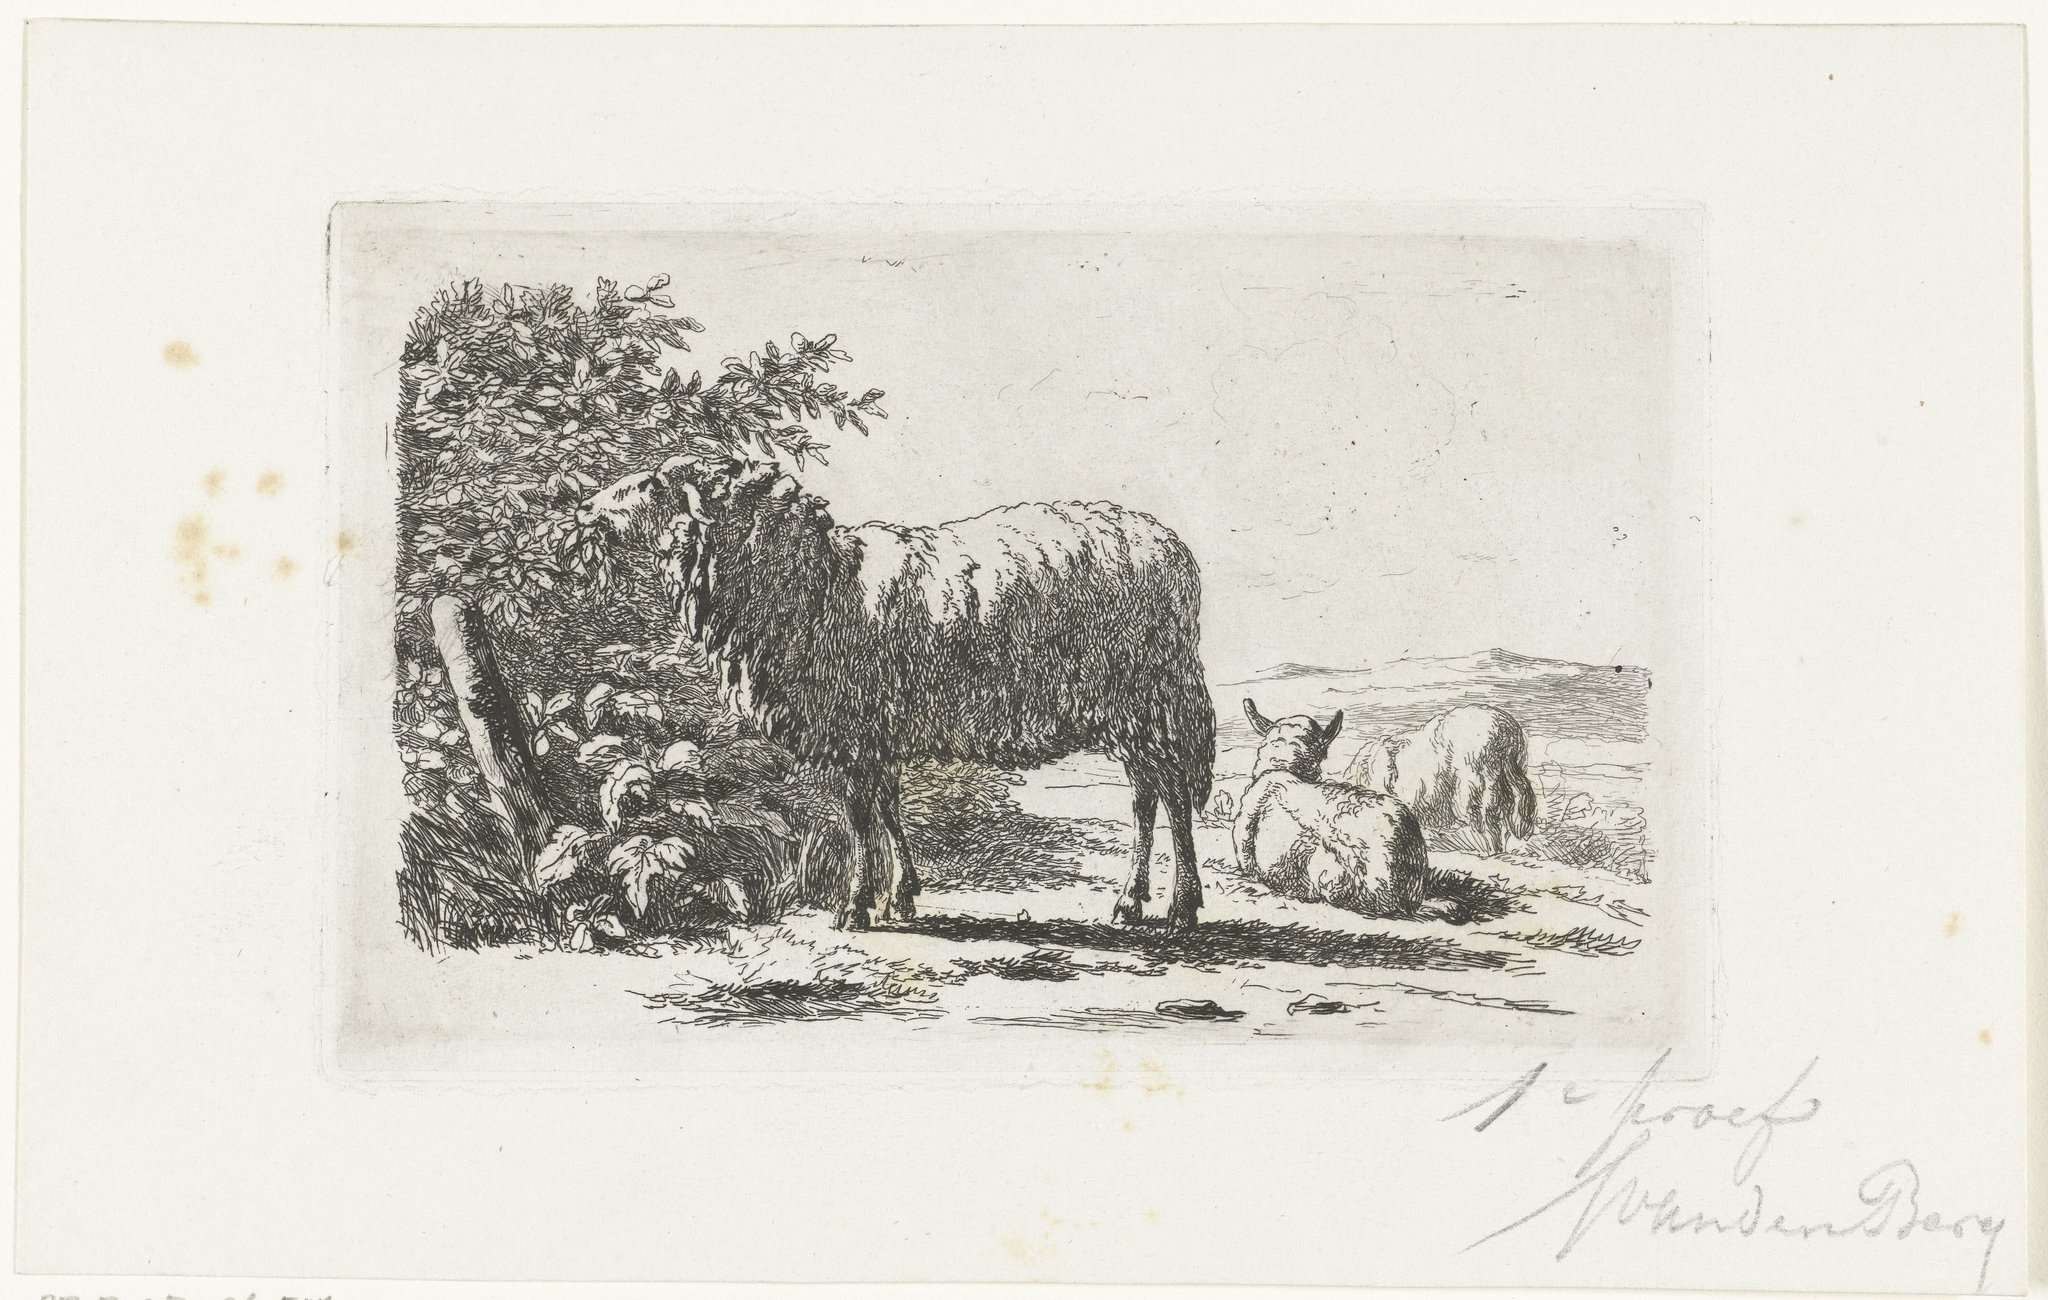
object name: print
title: Landschap met drie schapen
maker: simon van den berg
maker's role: draughtsman, print maker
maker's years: 1812-1891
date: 1822-1899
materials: paper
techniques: etching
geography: netherlands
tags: sheep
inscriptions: collector's mark: Lugt 2166, collector's mark: Lugt 2233, collector's mark: Lugt 2228